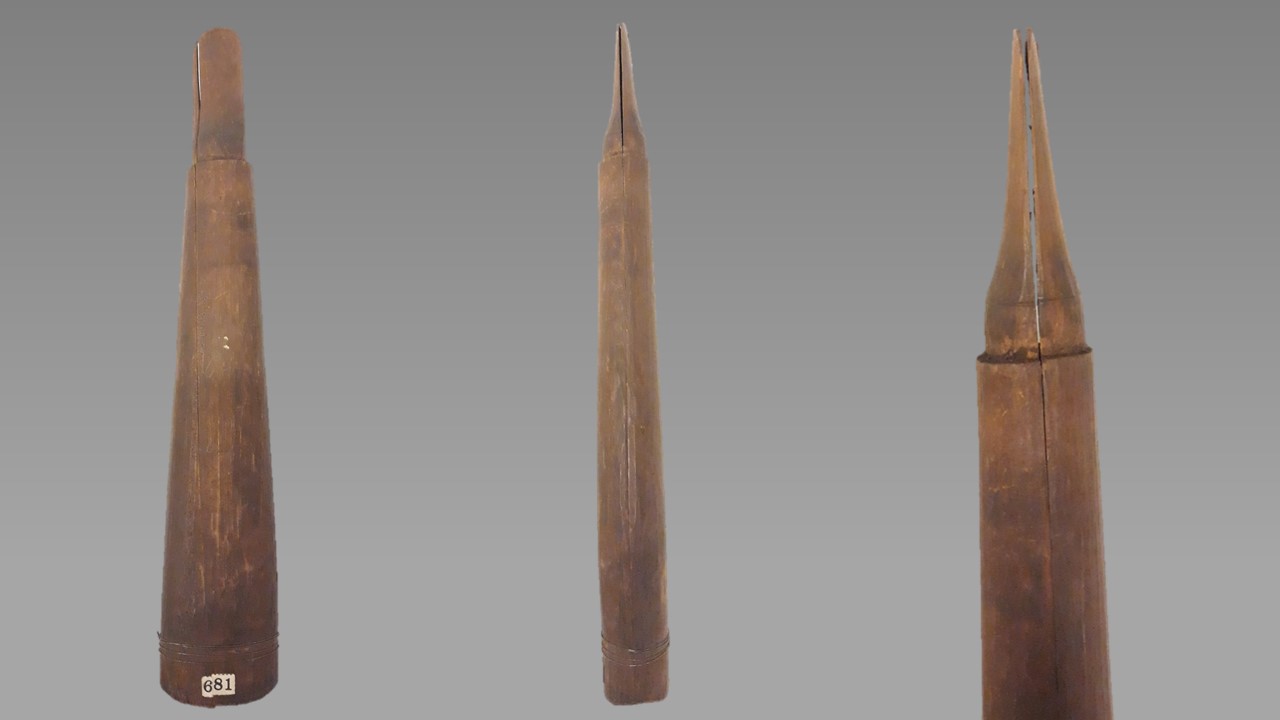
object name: reed pipe lipped form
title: Reed Pipe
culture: native american, tlingit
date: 1801-1900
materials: metal, wood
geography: united states